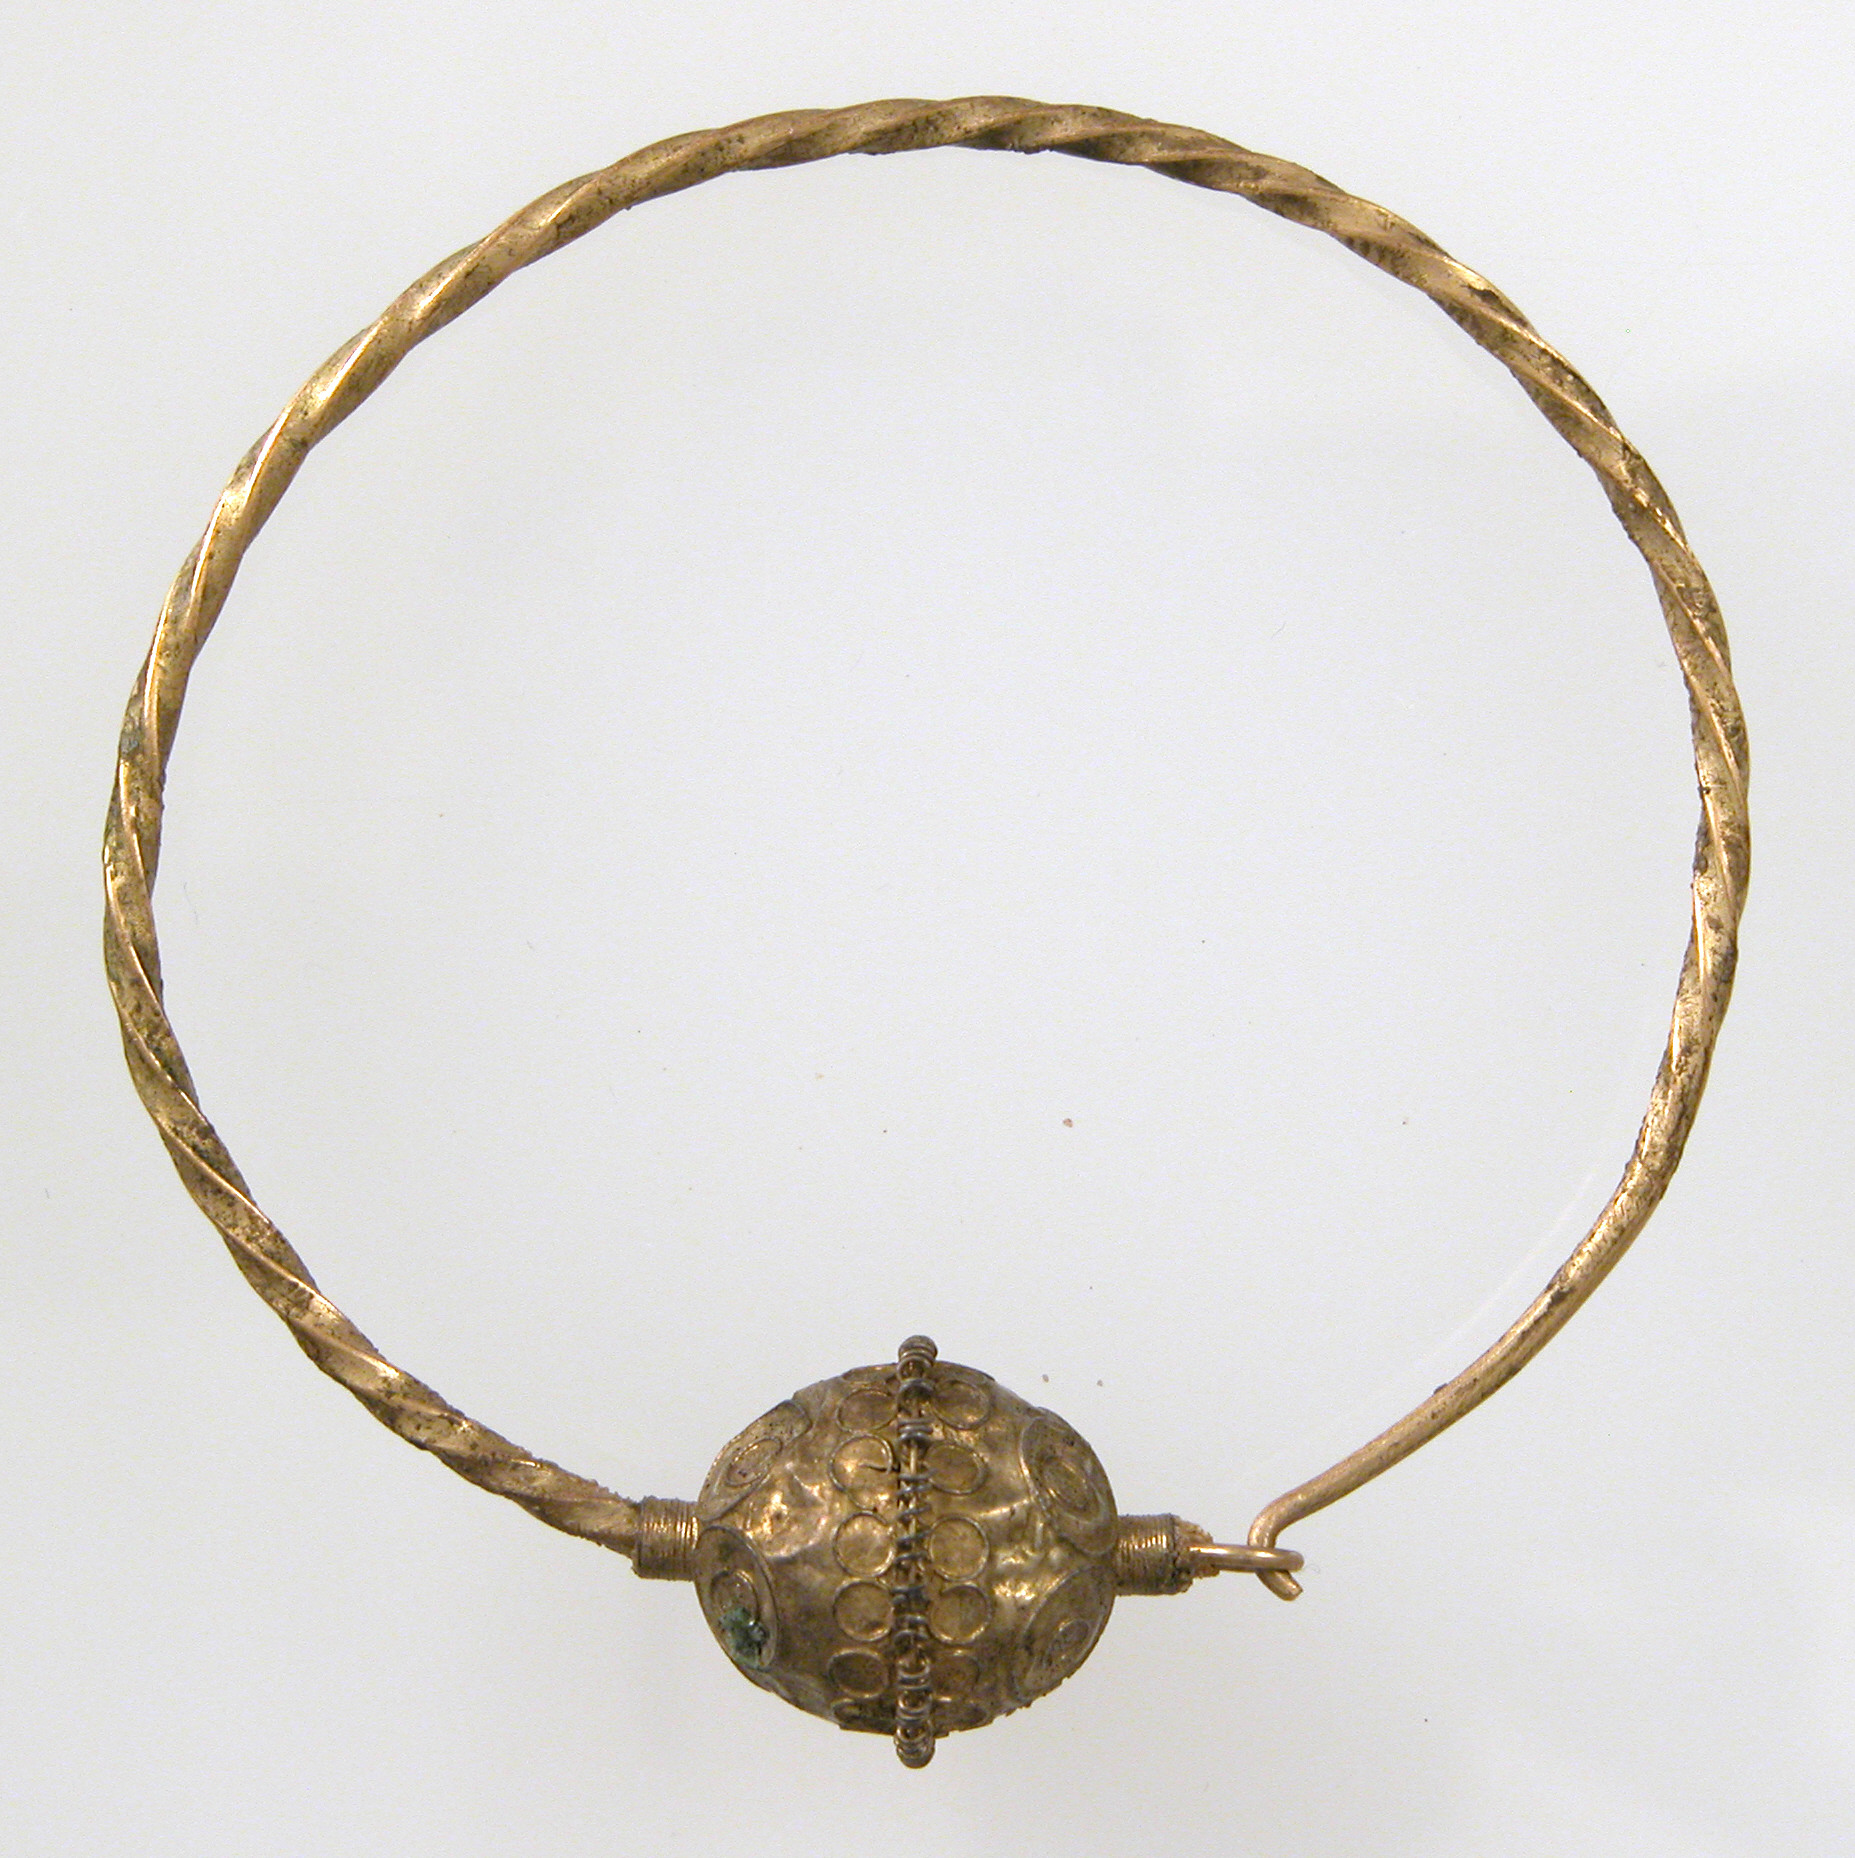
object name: earring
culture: langobardic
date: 501-700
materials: gold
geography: northern france